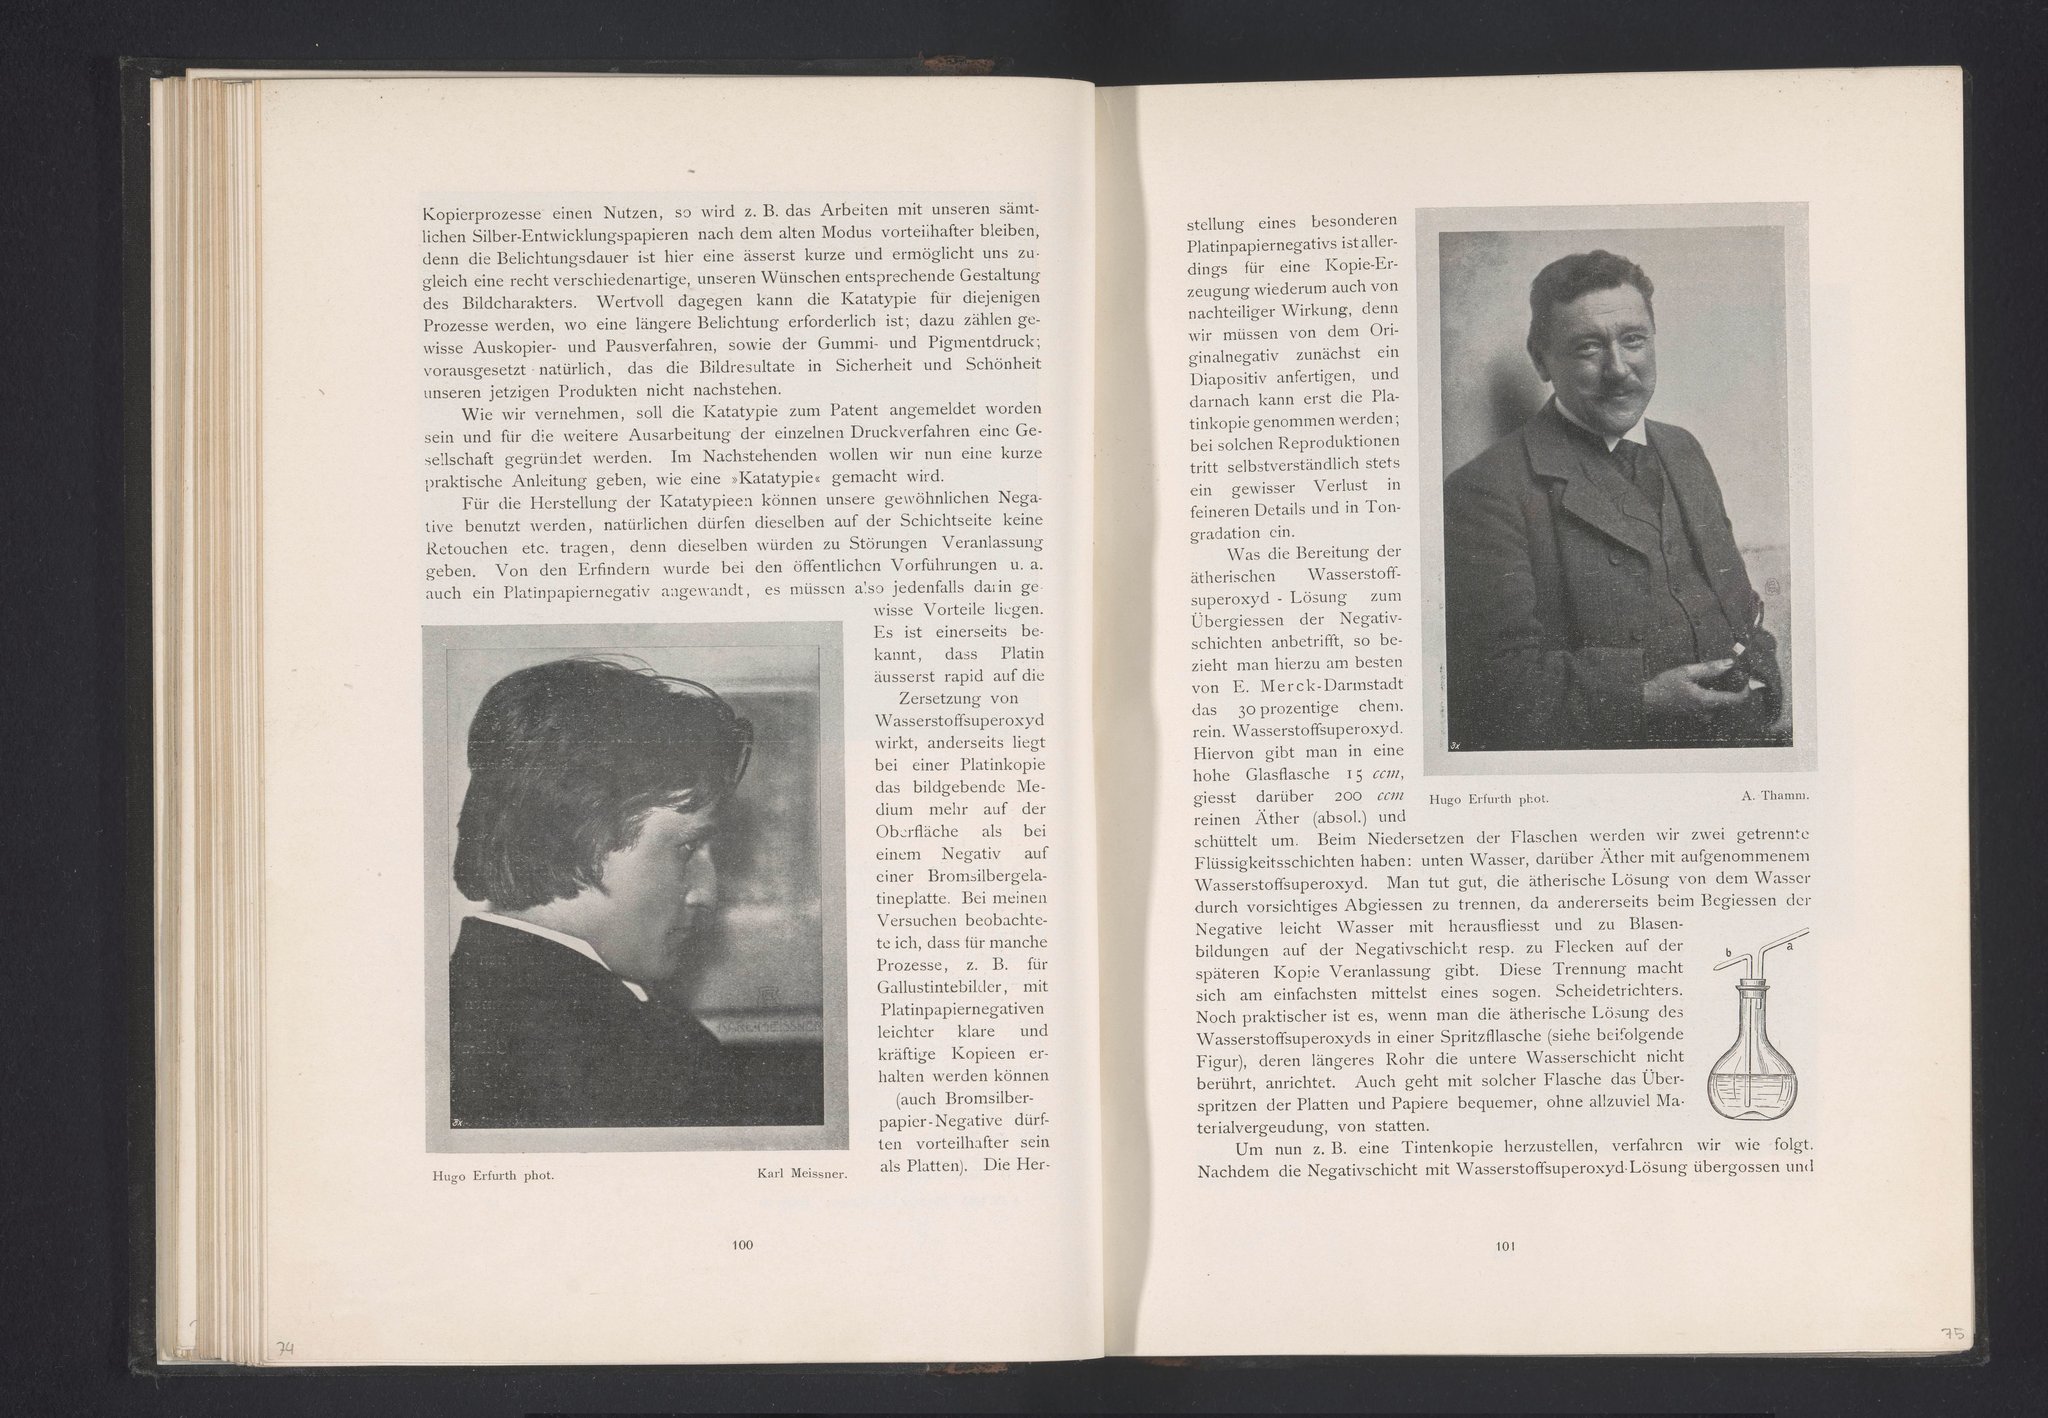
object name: page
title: Portret van Karl Meissner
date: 1898-1903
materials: paper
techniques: autotype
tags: historical persons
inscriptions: monogram: ‘BX’